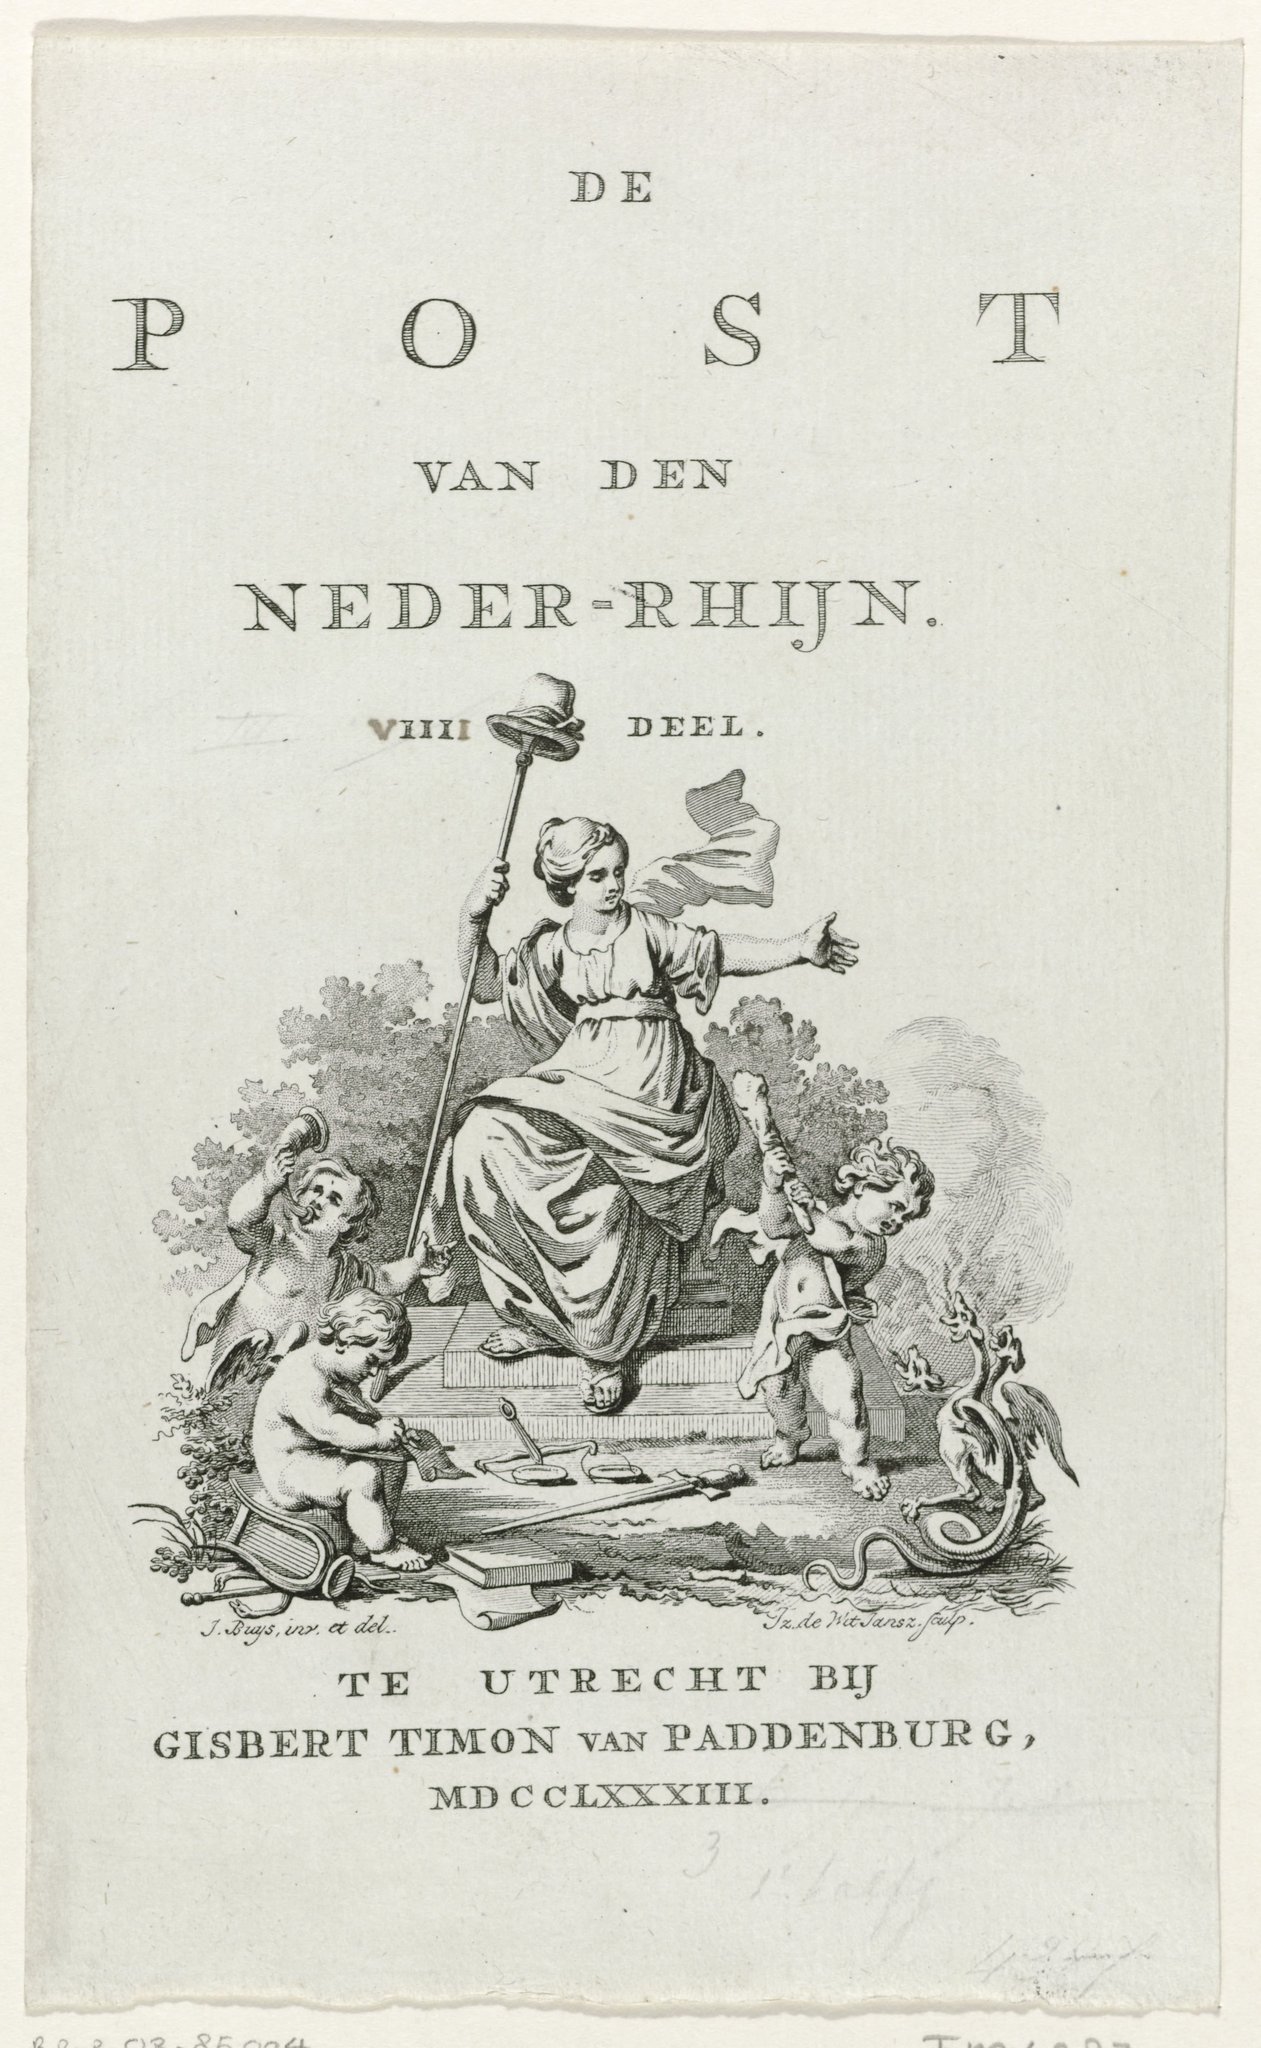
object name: print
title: Titelpagina: De Post van den Neder-Rhijn, dl. III, 1783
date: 1783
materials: paper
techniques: engraving, etching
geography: northern netherlands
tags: freedom, liberty; 'libertà' (ripa) (+ abstract concept represented by female figure), patriots (1780-1795)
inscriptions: collector's mark: Lugt 2228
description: Titelpagina van het patriotische tijdschrift De Post van den Neder-Rhijn, dl. III, 1783. Allegorische voorstelling waarin de Vrijheid centraal op een verhoging zit, rechts verjaagt een kind een driekoppige slang.